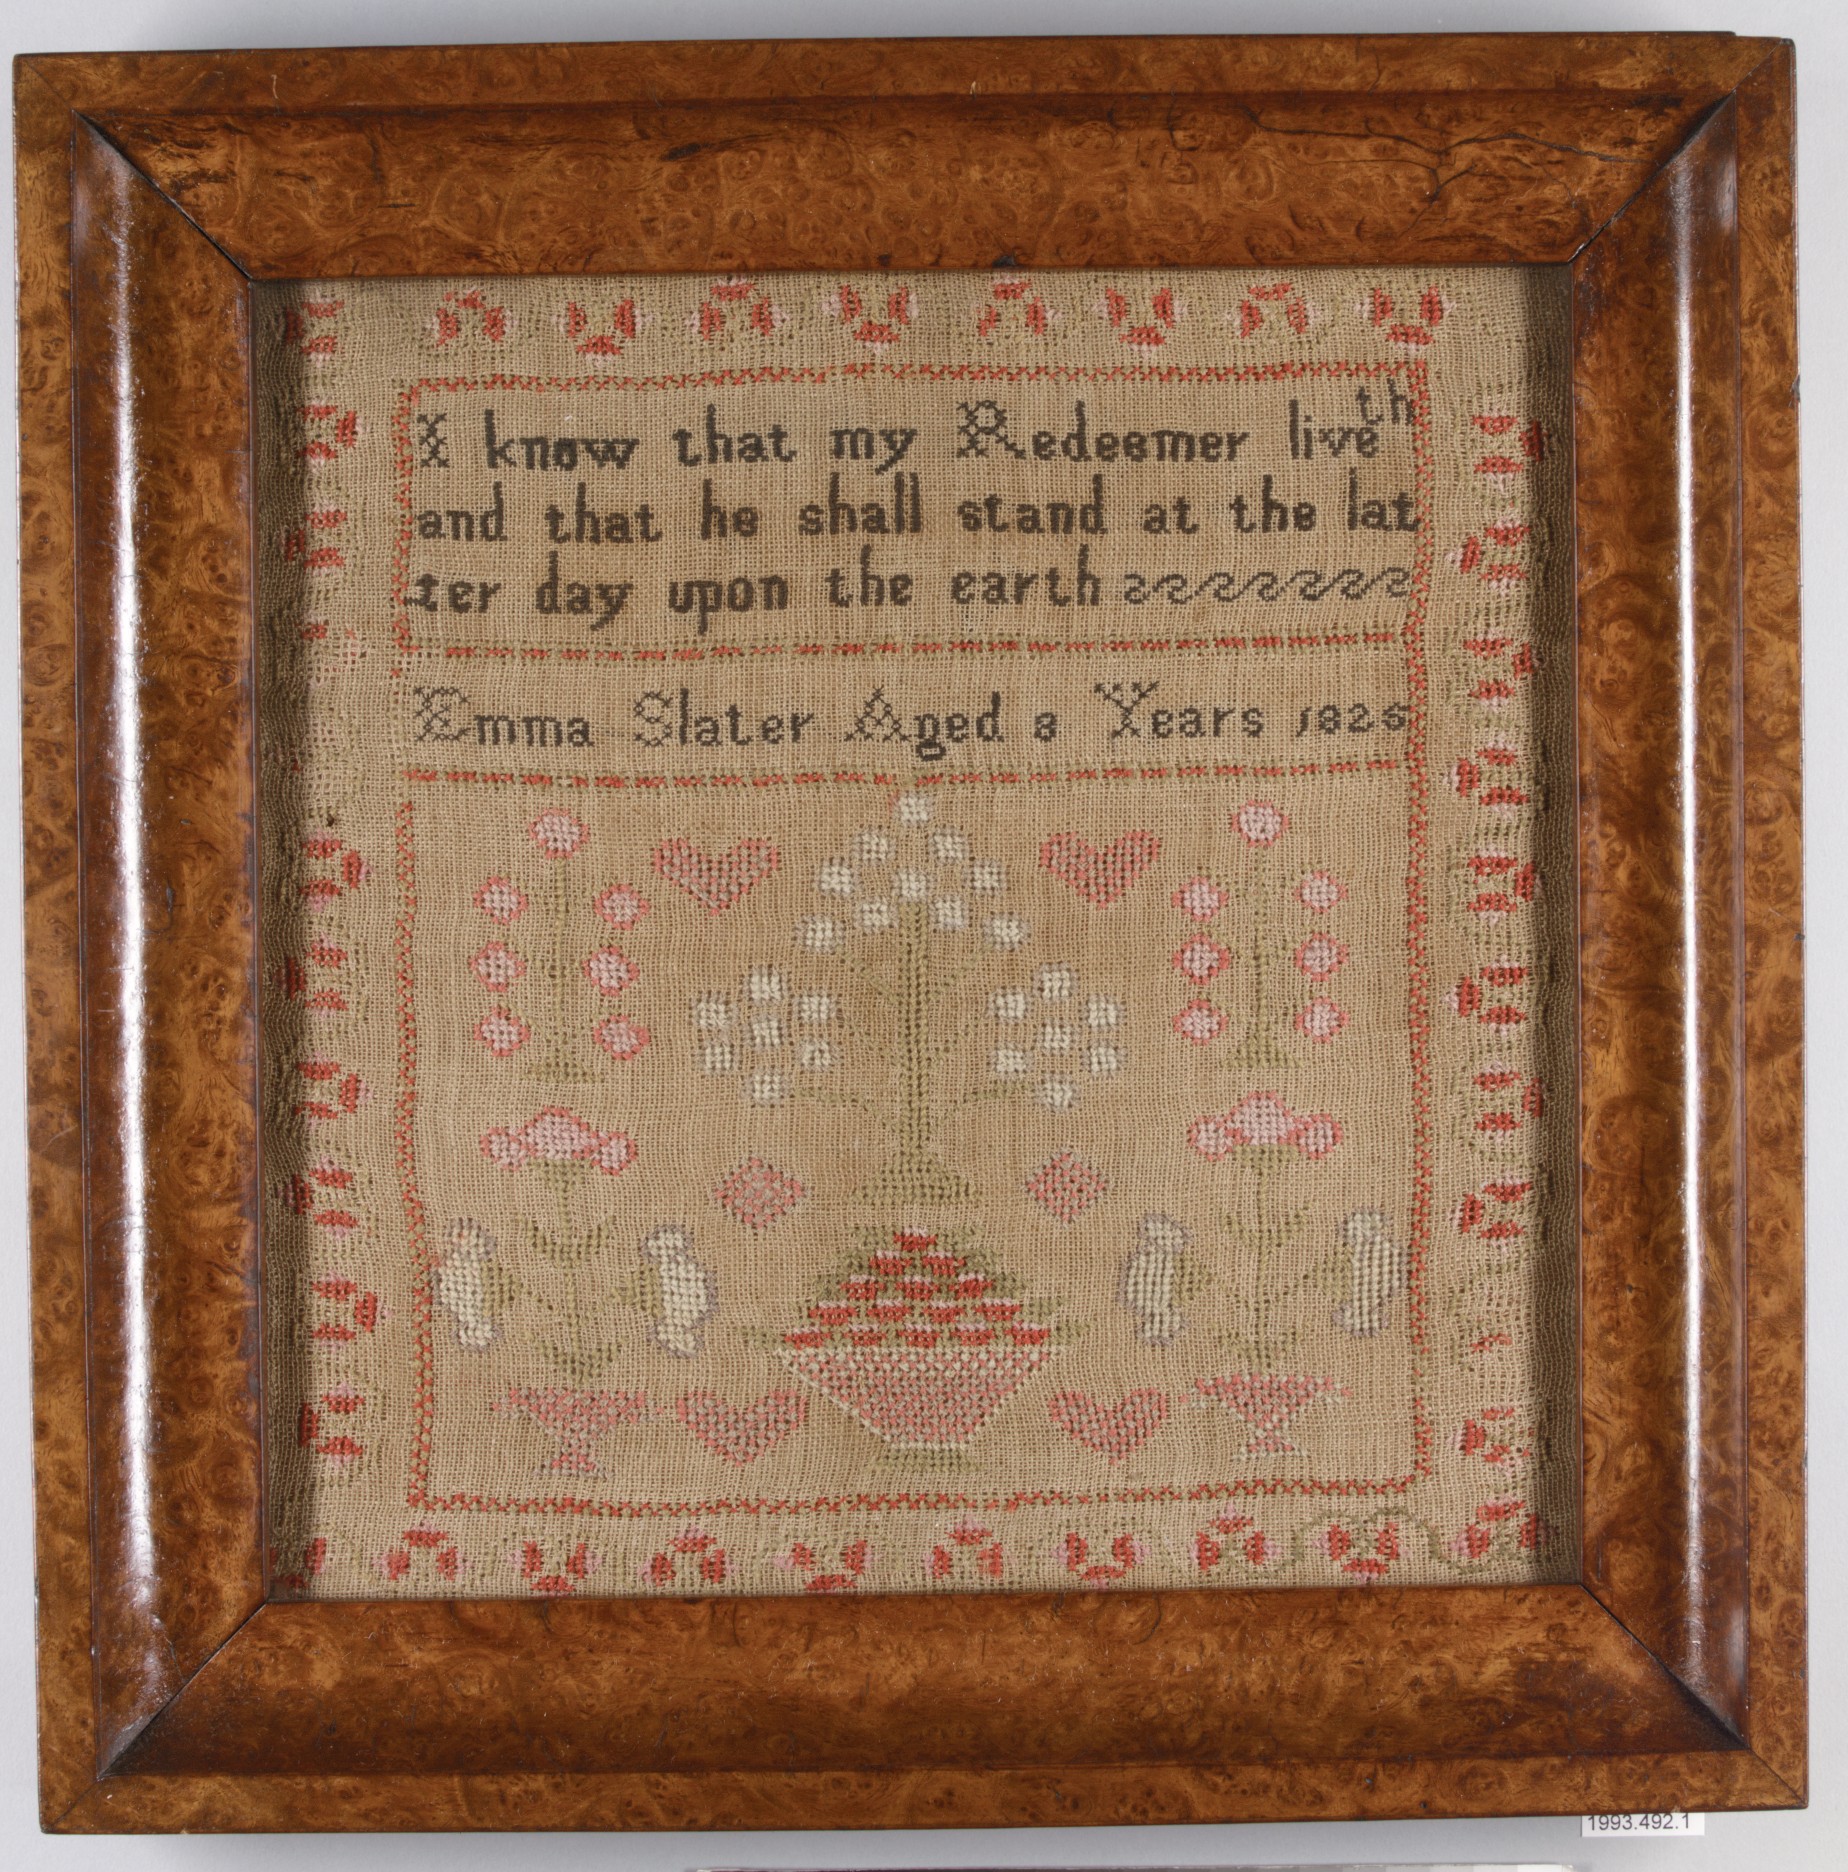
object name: sampler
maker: emma slater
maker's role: maker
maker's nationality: british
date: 1825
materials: linen, silk, wood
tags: flowers